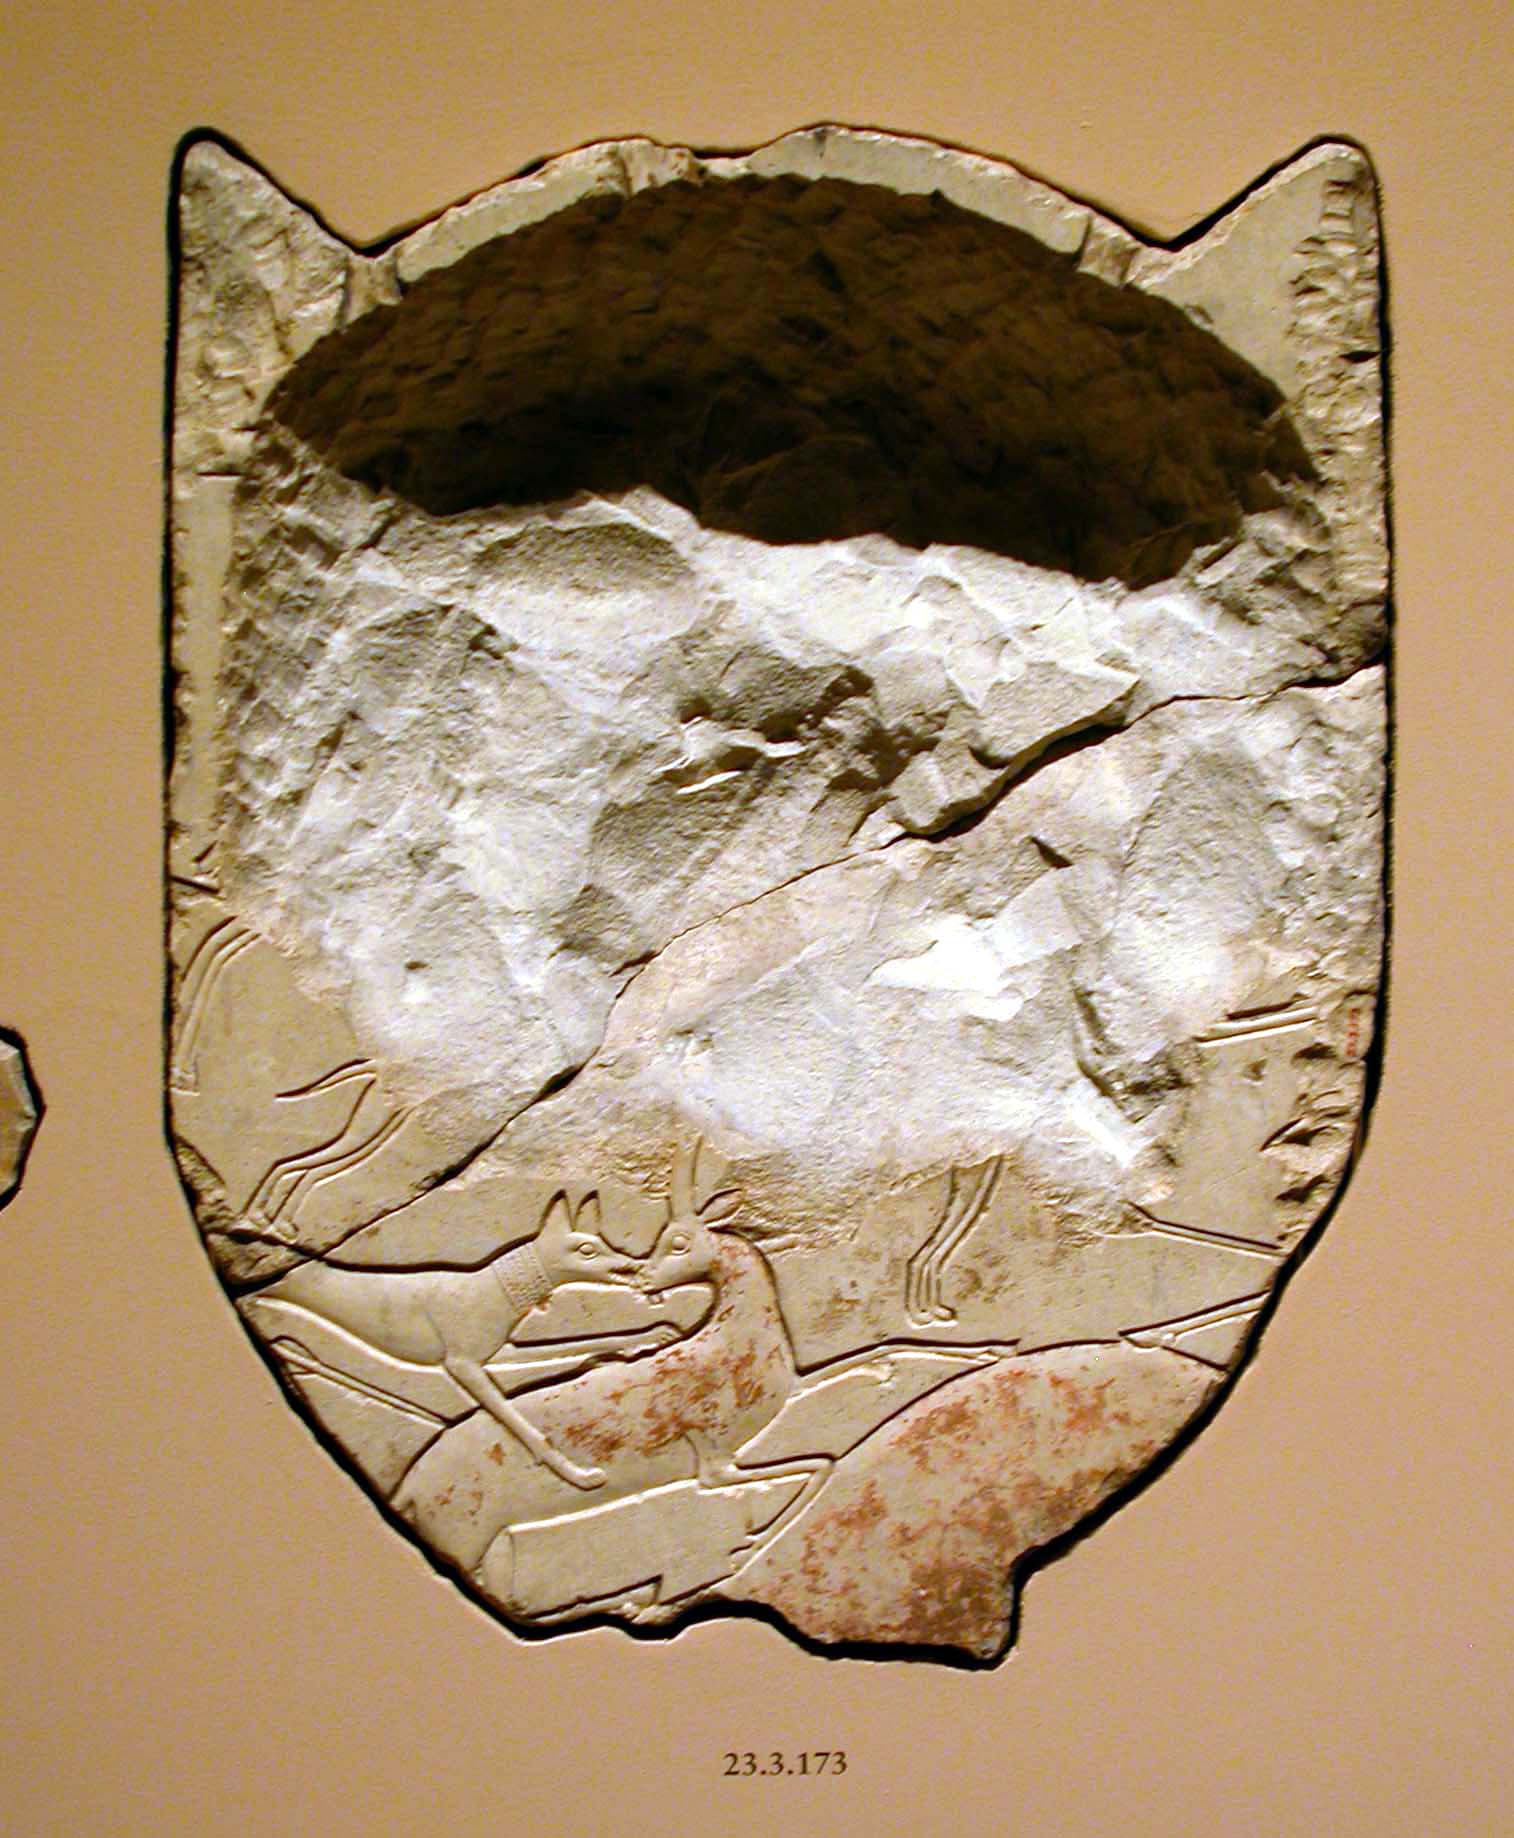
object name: relief, tomb of khety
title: Fragment of a desert hunt - see 26.3.354-5-related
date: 2051-2000 BCE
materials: limestone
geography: egypt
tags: animals